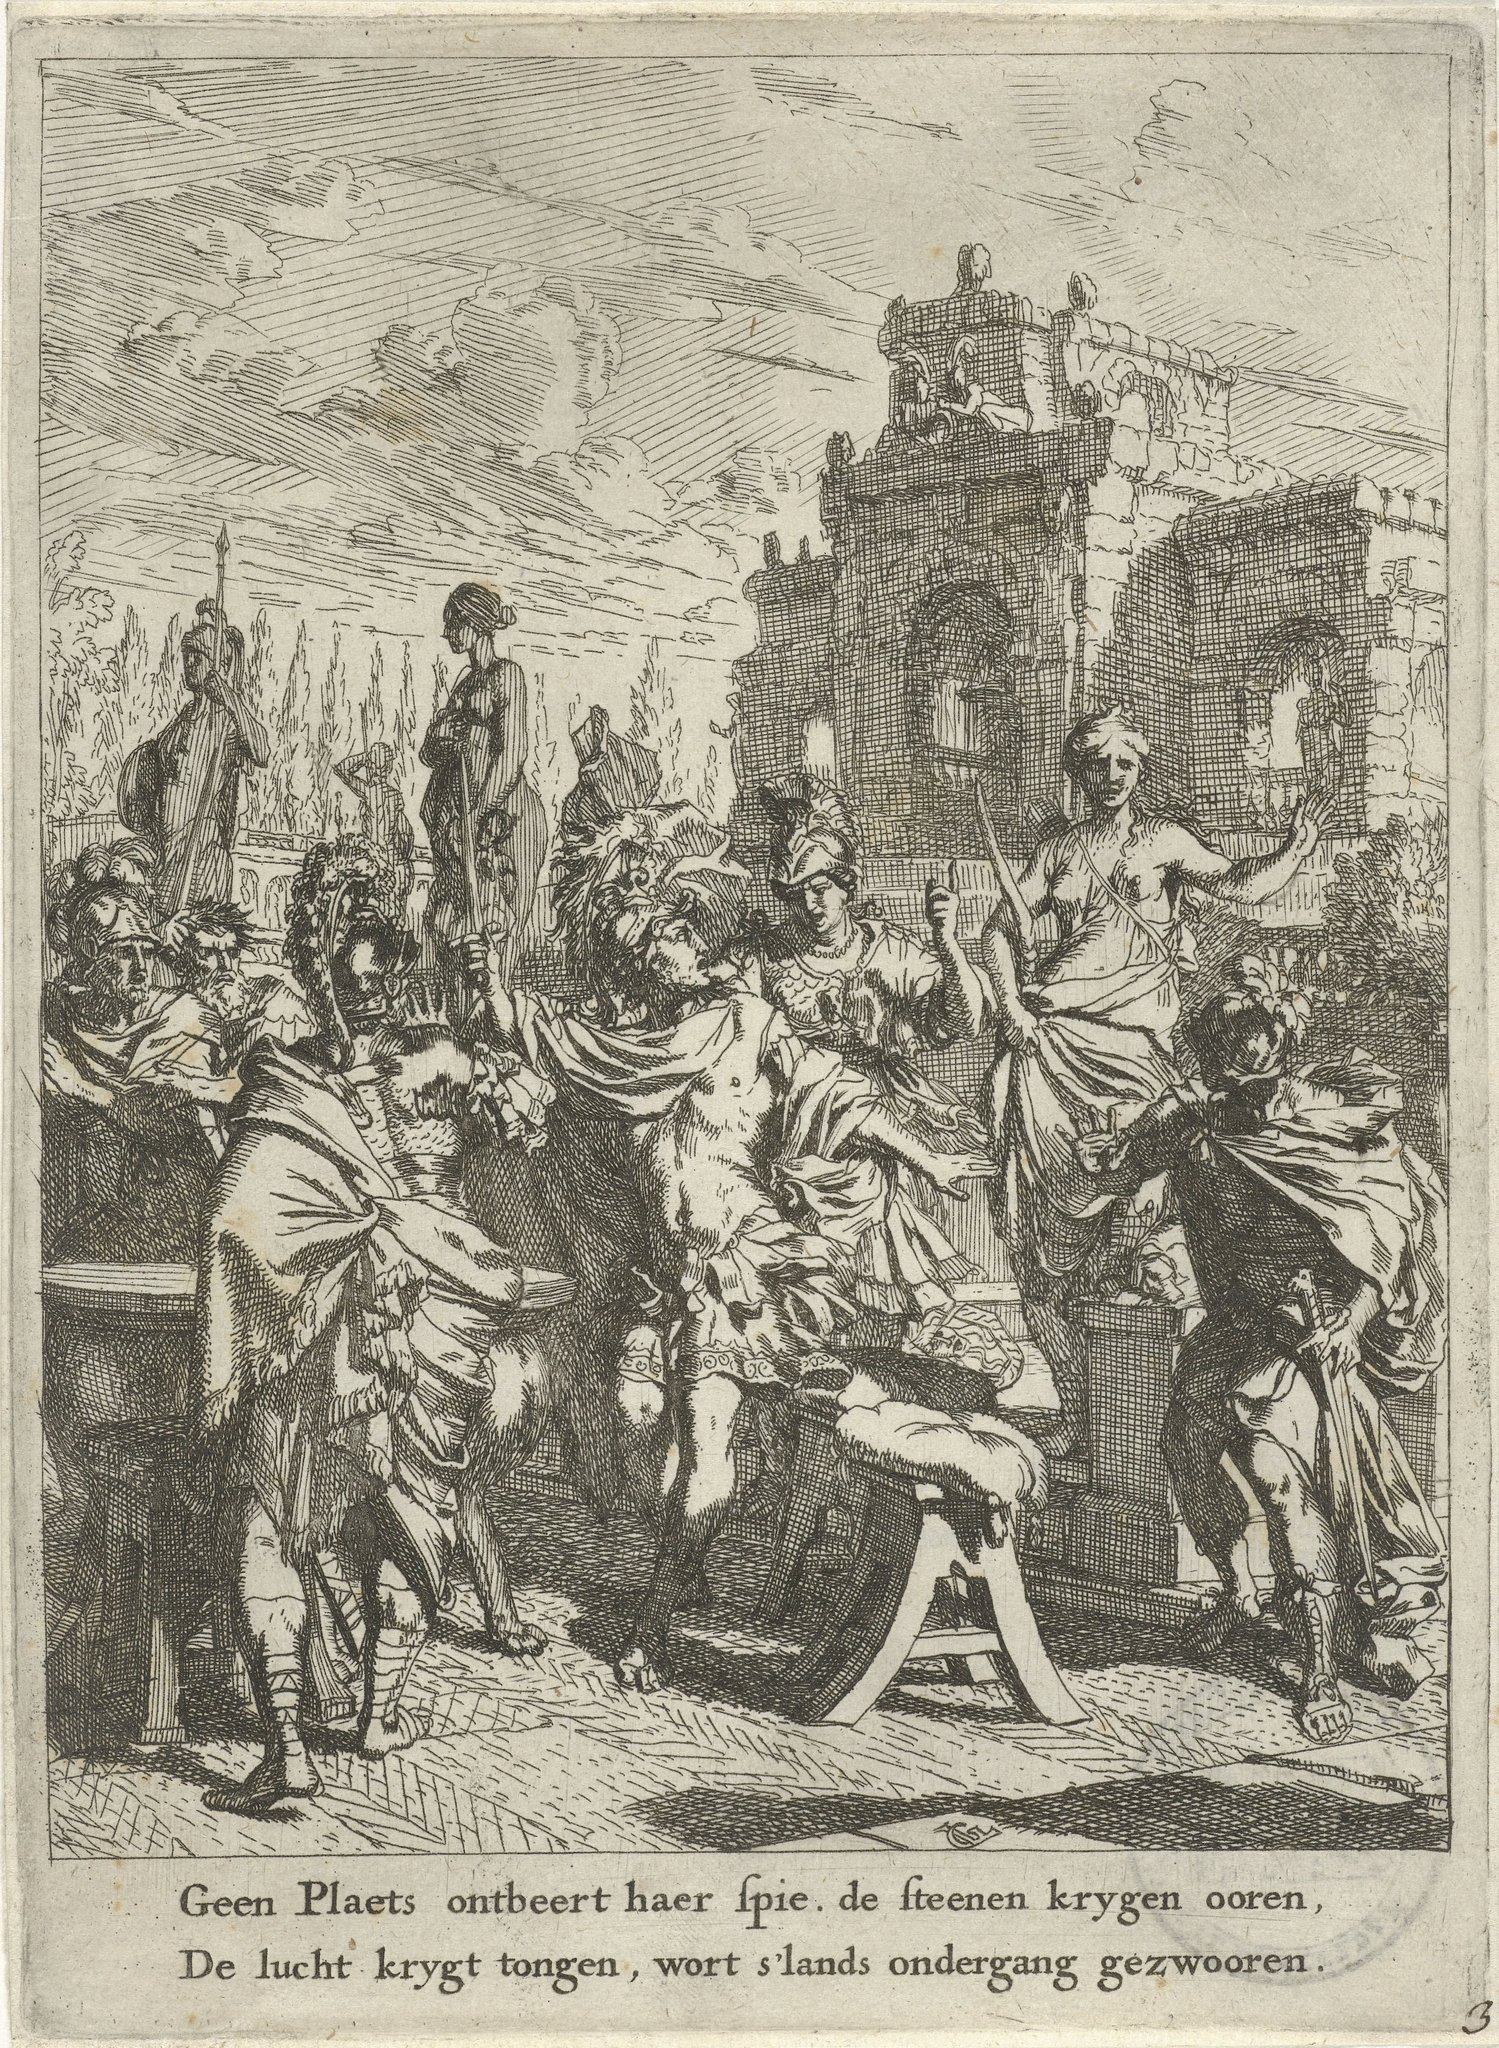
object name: print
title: Illustraties bij het treurspel "Didoos Doot"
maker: gerard de lairesse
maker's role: draughtsman, painter, print maker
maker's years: 1641-1711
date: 1668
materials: paper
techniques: etching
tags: (story of) dido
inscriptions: number: ‘3’, collector's mark: Lugt 10, collector's mark: Lugt 11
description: De beraadslaging die Aeneas met zijn volgelingen voert, wordt door Dido en haar zuster Anna onderbroken. In de marge staat een tweeregelig onderschrift in het Nederlands. Deze illustratie is vervaardigd bij het tweede bedrijf van het treurspel "Didoos Doot" (1668), geschreven door Andries Pels. De prent maakt deel uit van een vierdelige serie met scènes uit dit treurspel.